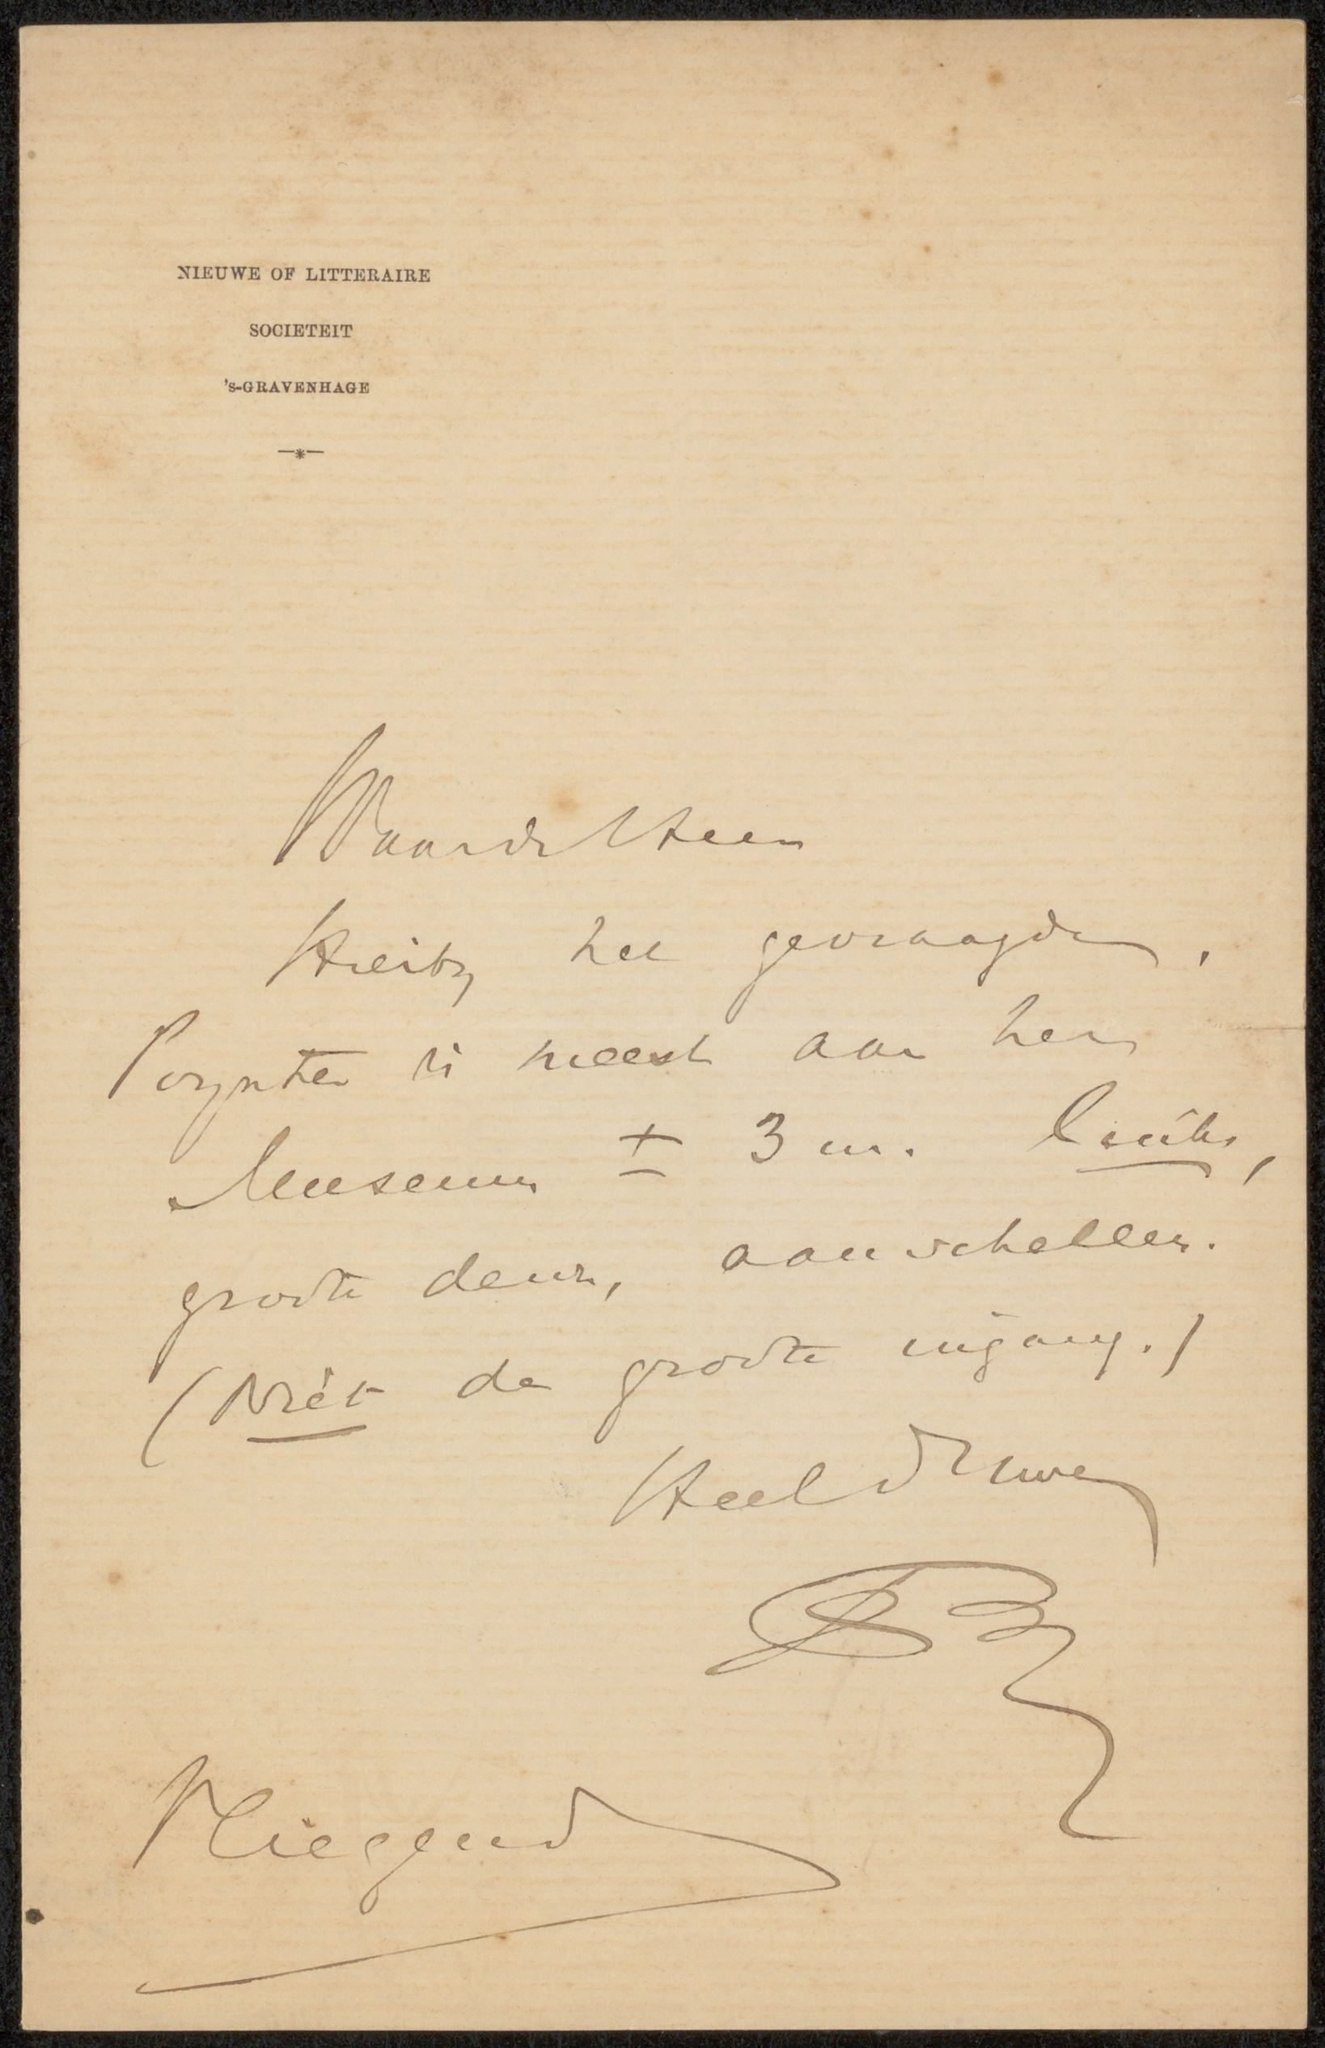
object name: letter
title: Brief aan Philip Zilcken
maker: abraham bredius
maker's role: kunsthistoricus, museumdirecteur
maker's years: 1855-1946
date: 1865-1946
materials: ink, paper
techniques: pen, printing, writing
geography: the hague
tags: edward john poynter (sir), painter, draughtsman, philip zilcken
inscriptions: collector's mark: ‘RPK’